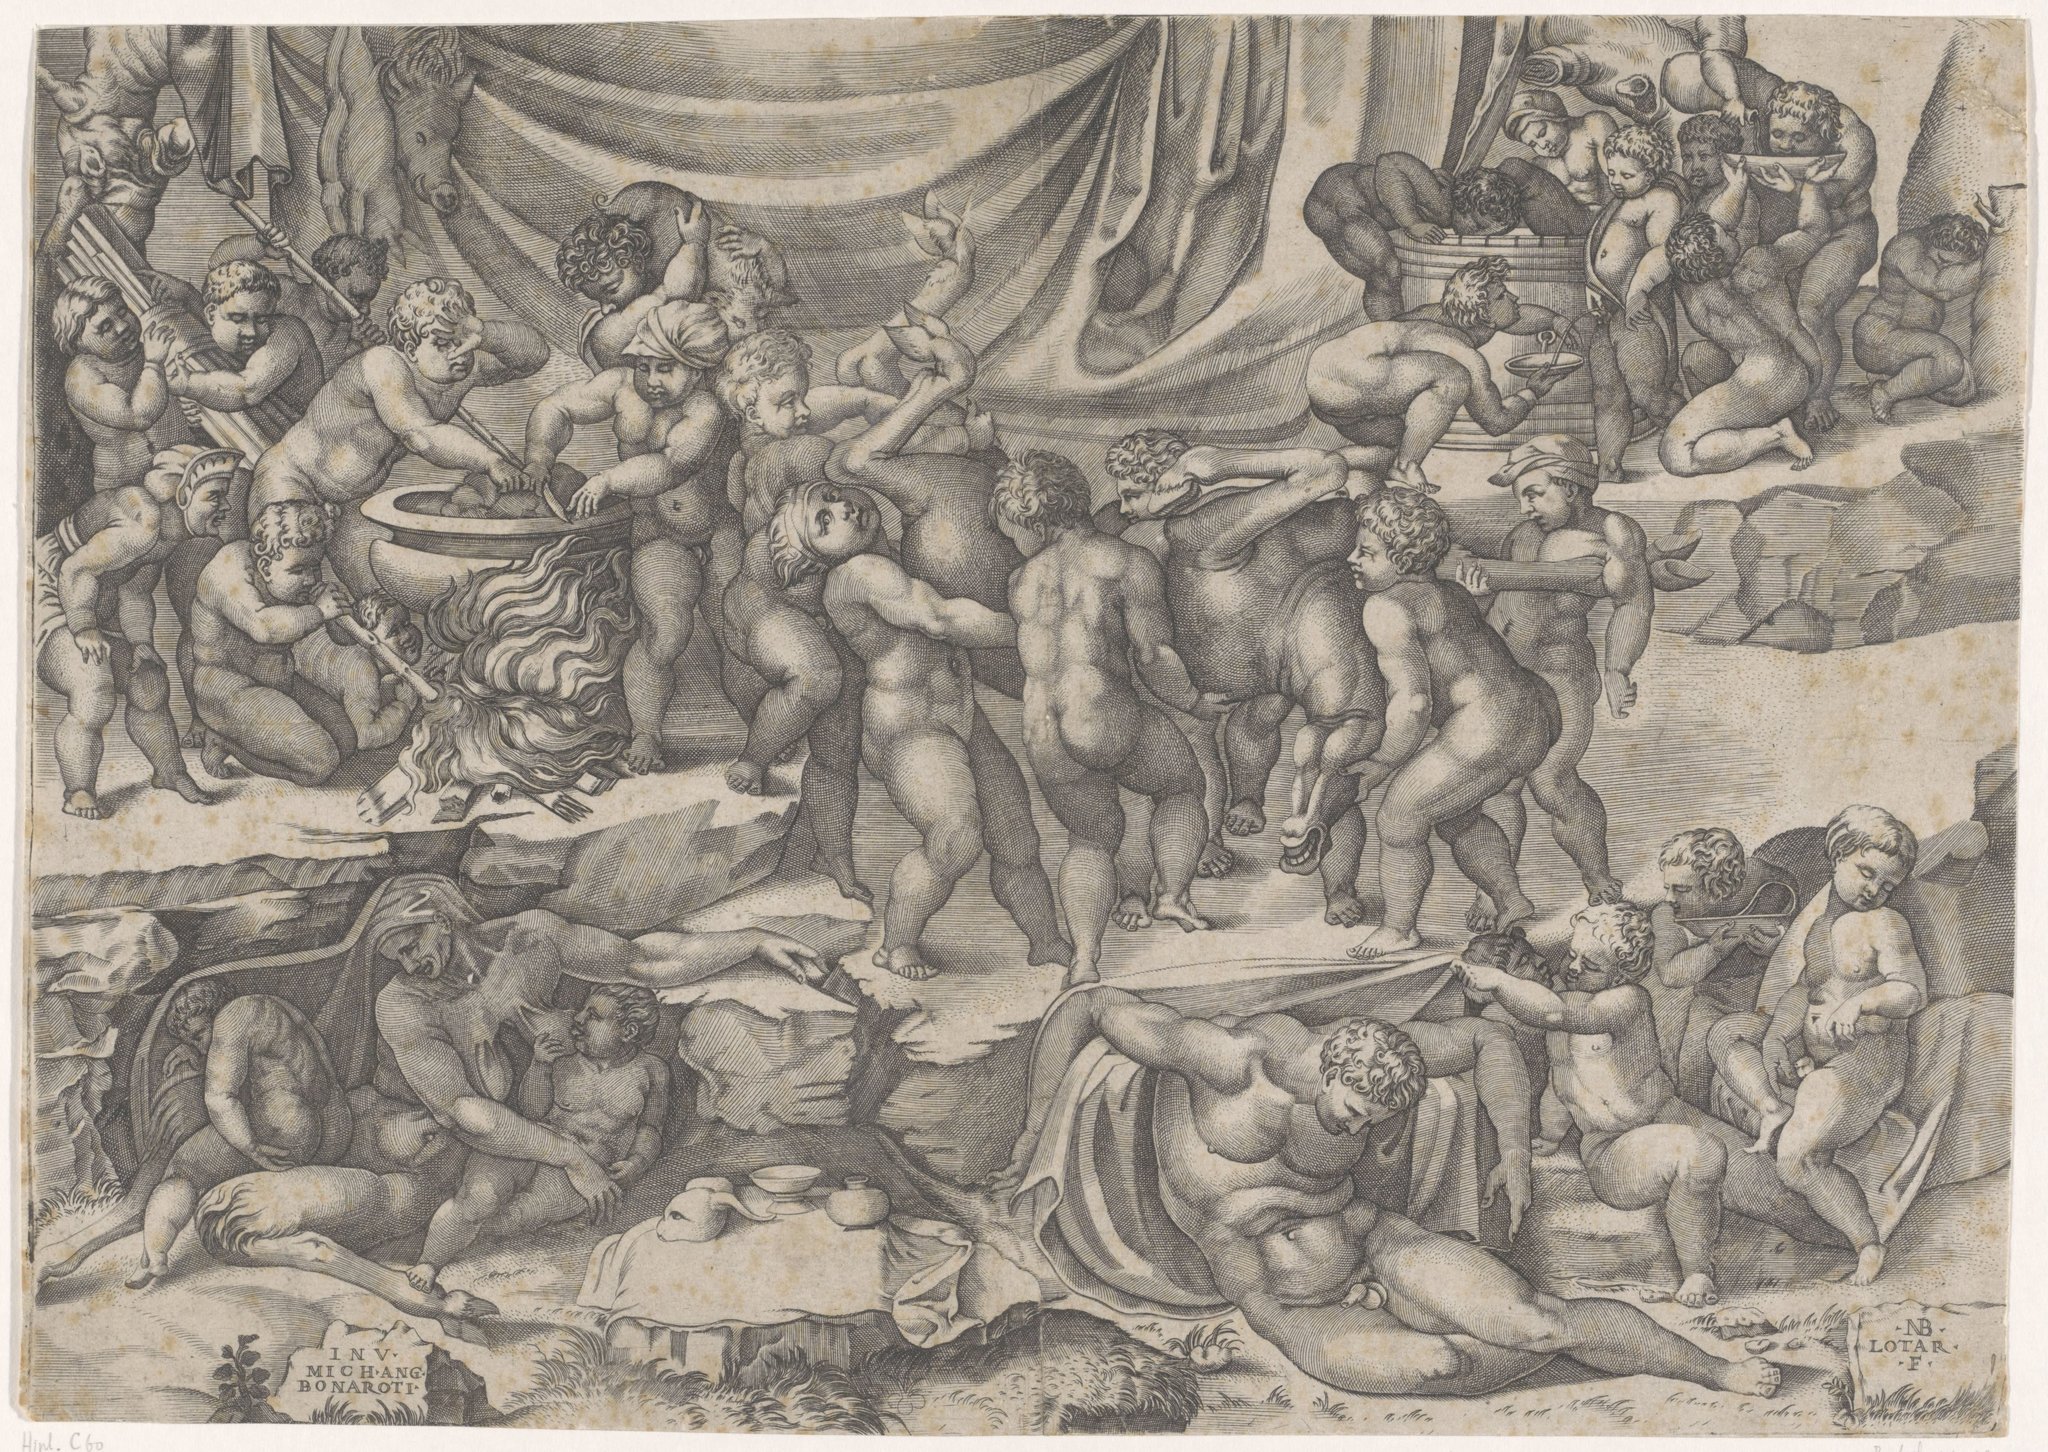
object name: print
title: Bacchanaal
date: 1525-1565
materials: paper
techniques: engraving, etching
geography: italy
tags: cupids: 'amores', 'amoretti', 'putti'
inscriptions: collector's mark: Lugt 10, collector's mark: ‘Hinloopen’, collector's mark: Lugt 11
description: Een bacchanaal met putti. In het midden putti die een ezel dragen. Linksonder een sater die een putto zoogt. Rechtsonder een naakte man.